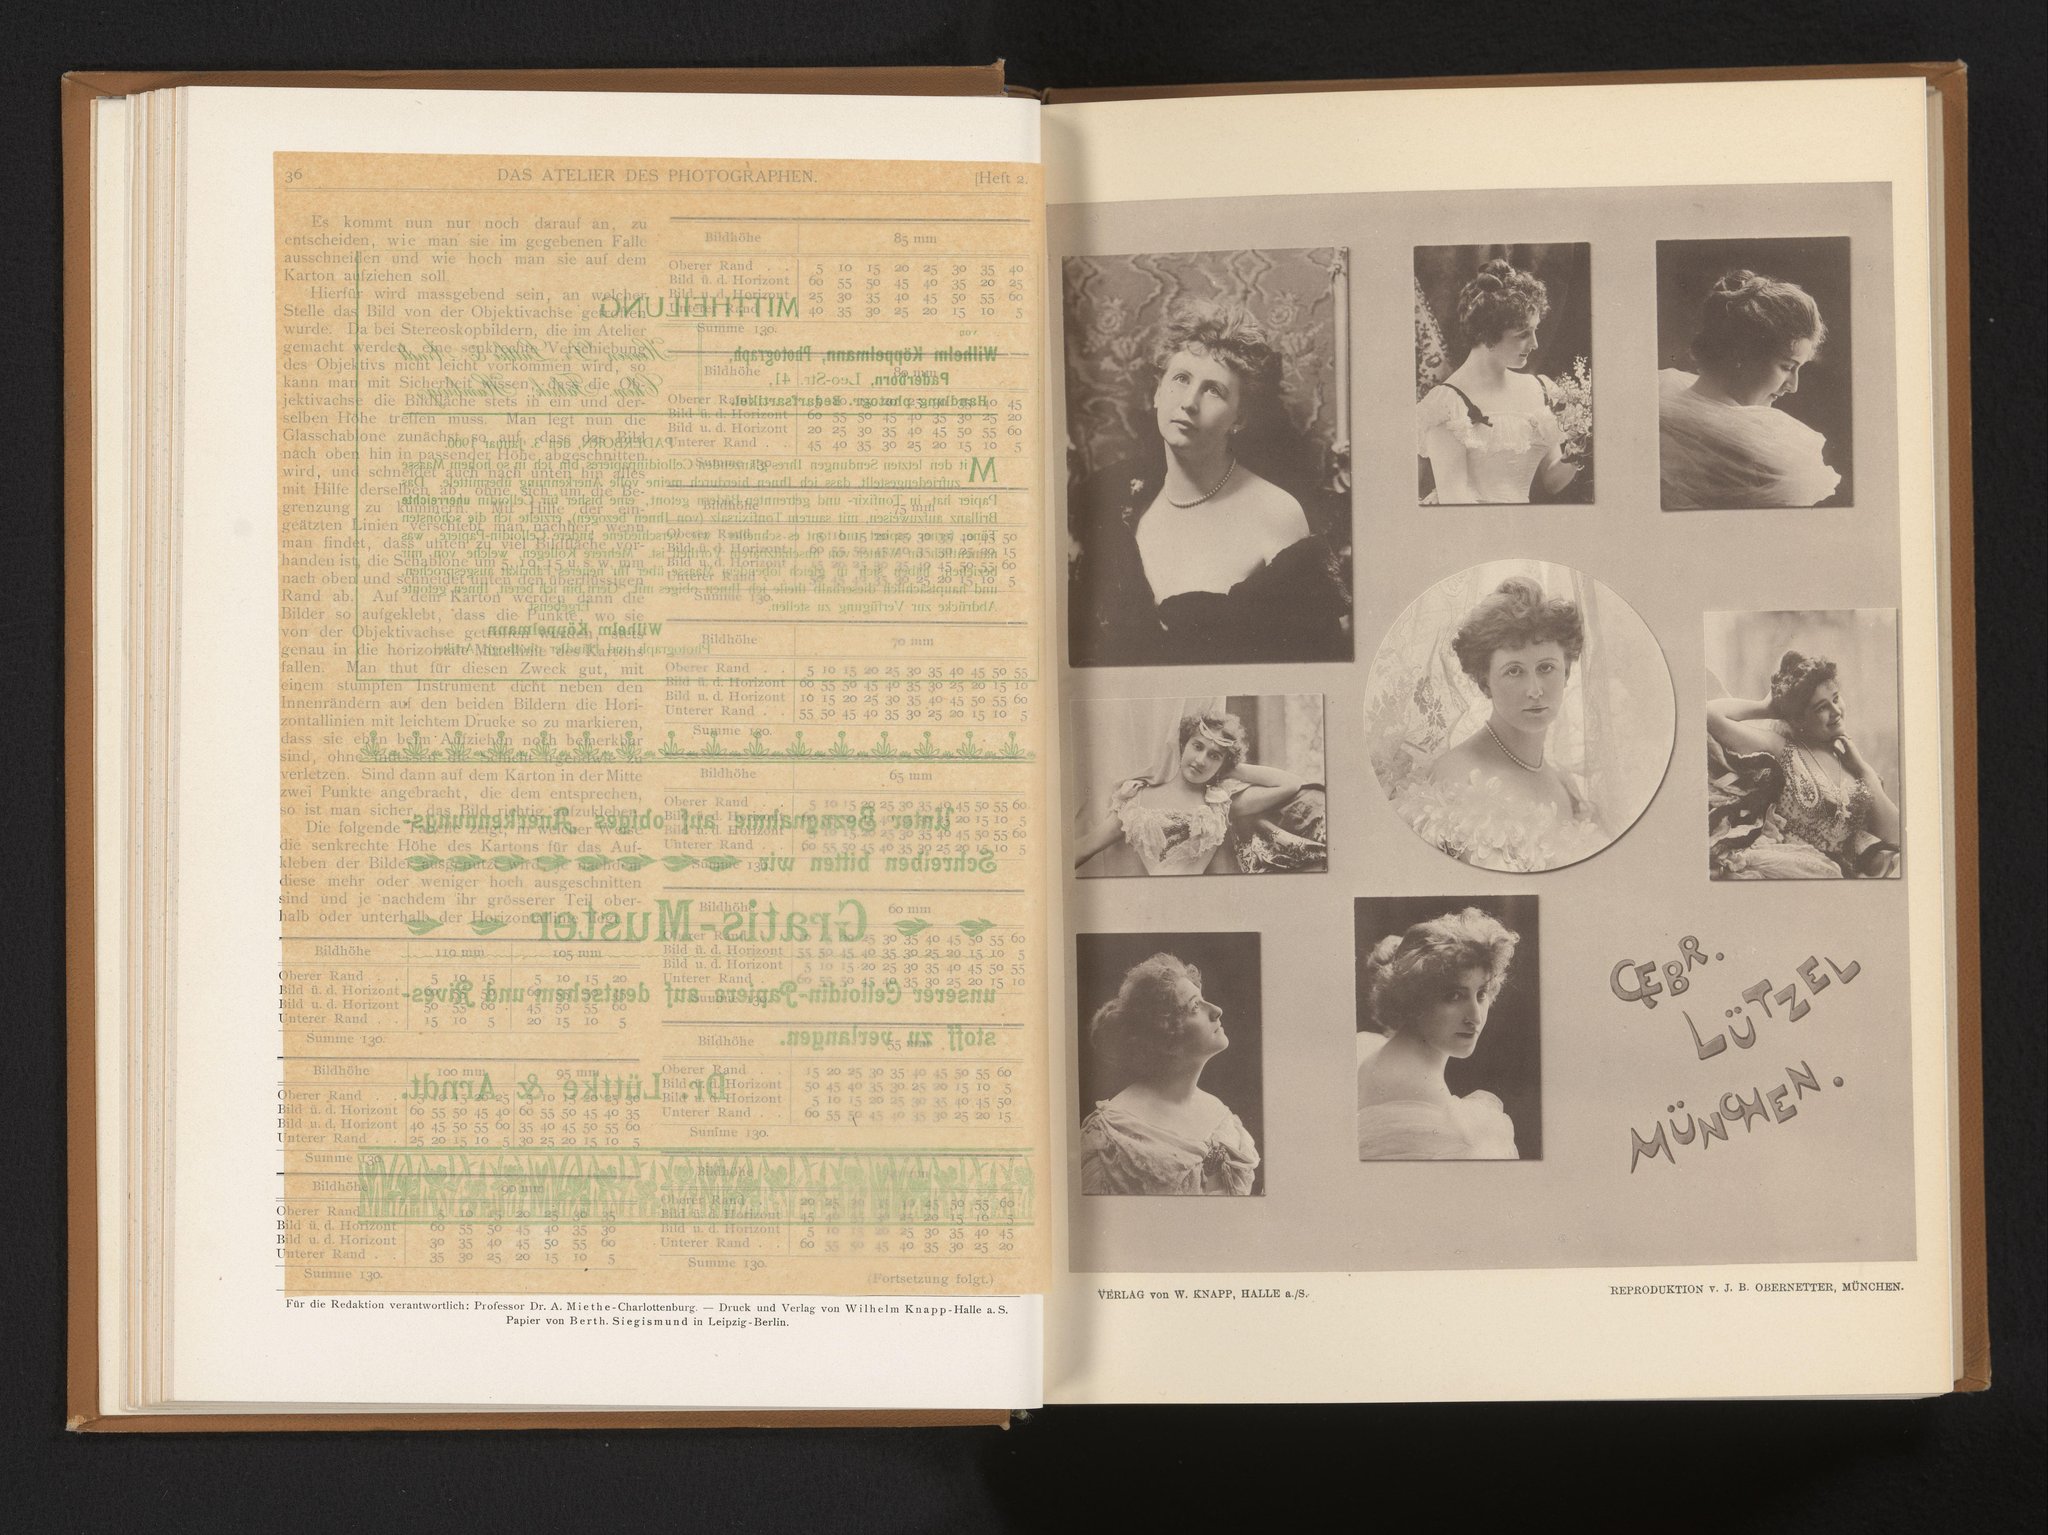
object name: photomechanical print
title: Acht portretten van onbekende vrouwen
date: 1895-1900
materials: paper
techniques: photograph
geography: halle an der saale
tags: historical persons - bb - woman